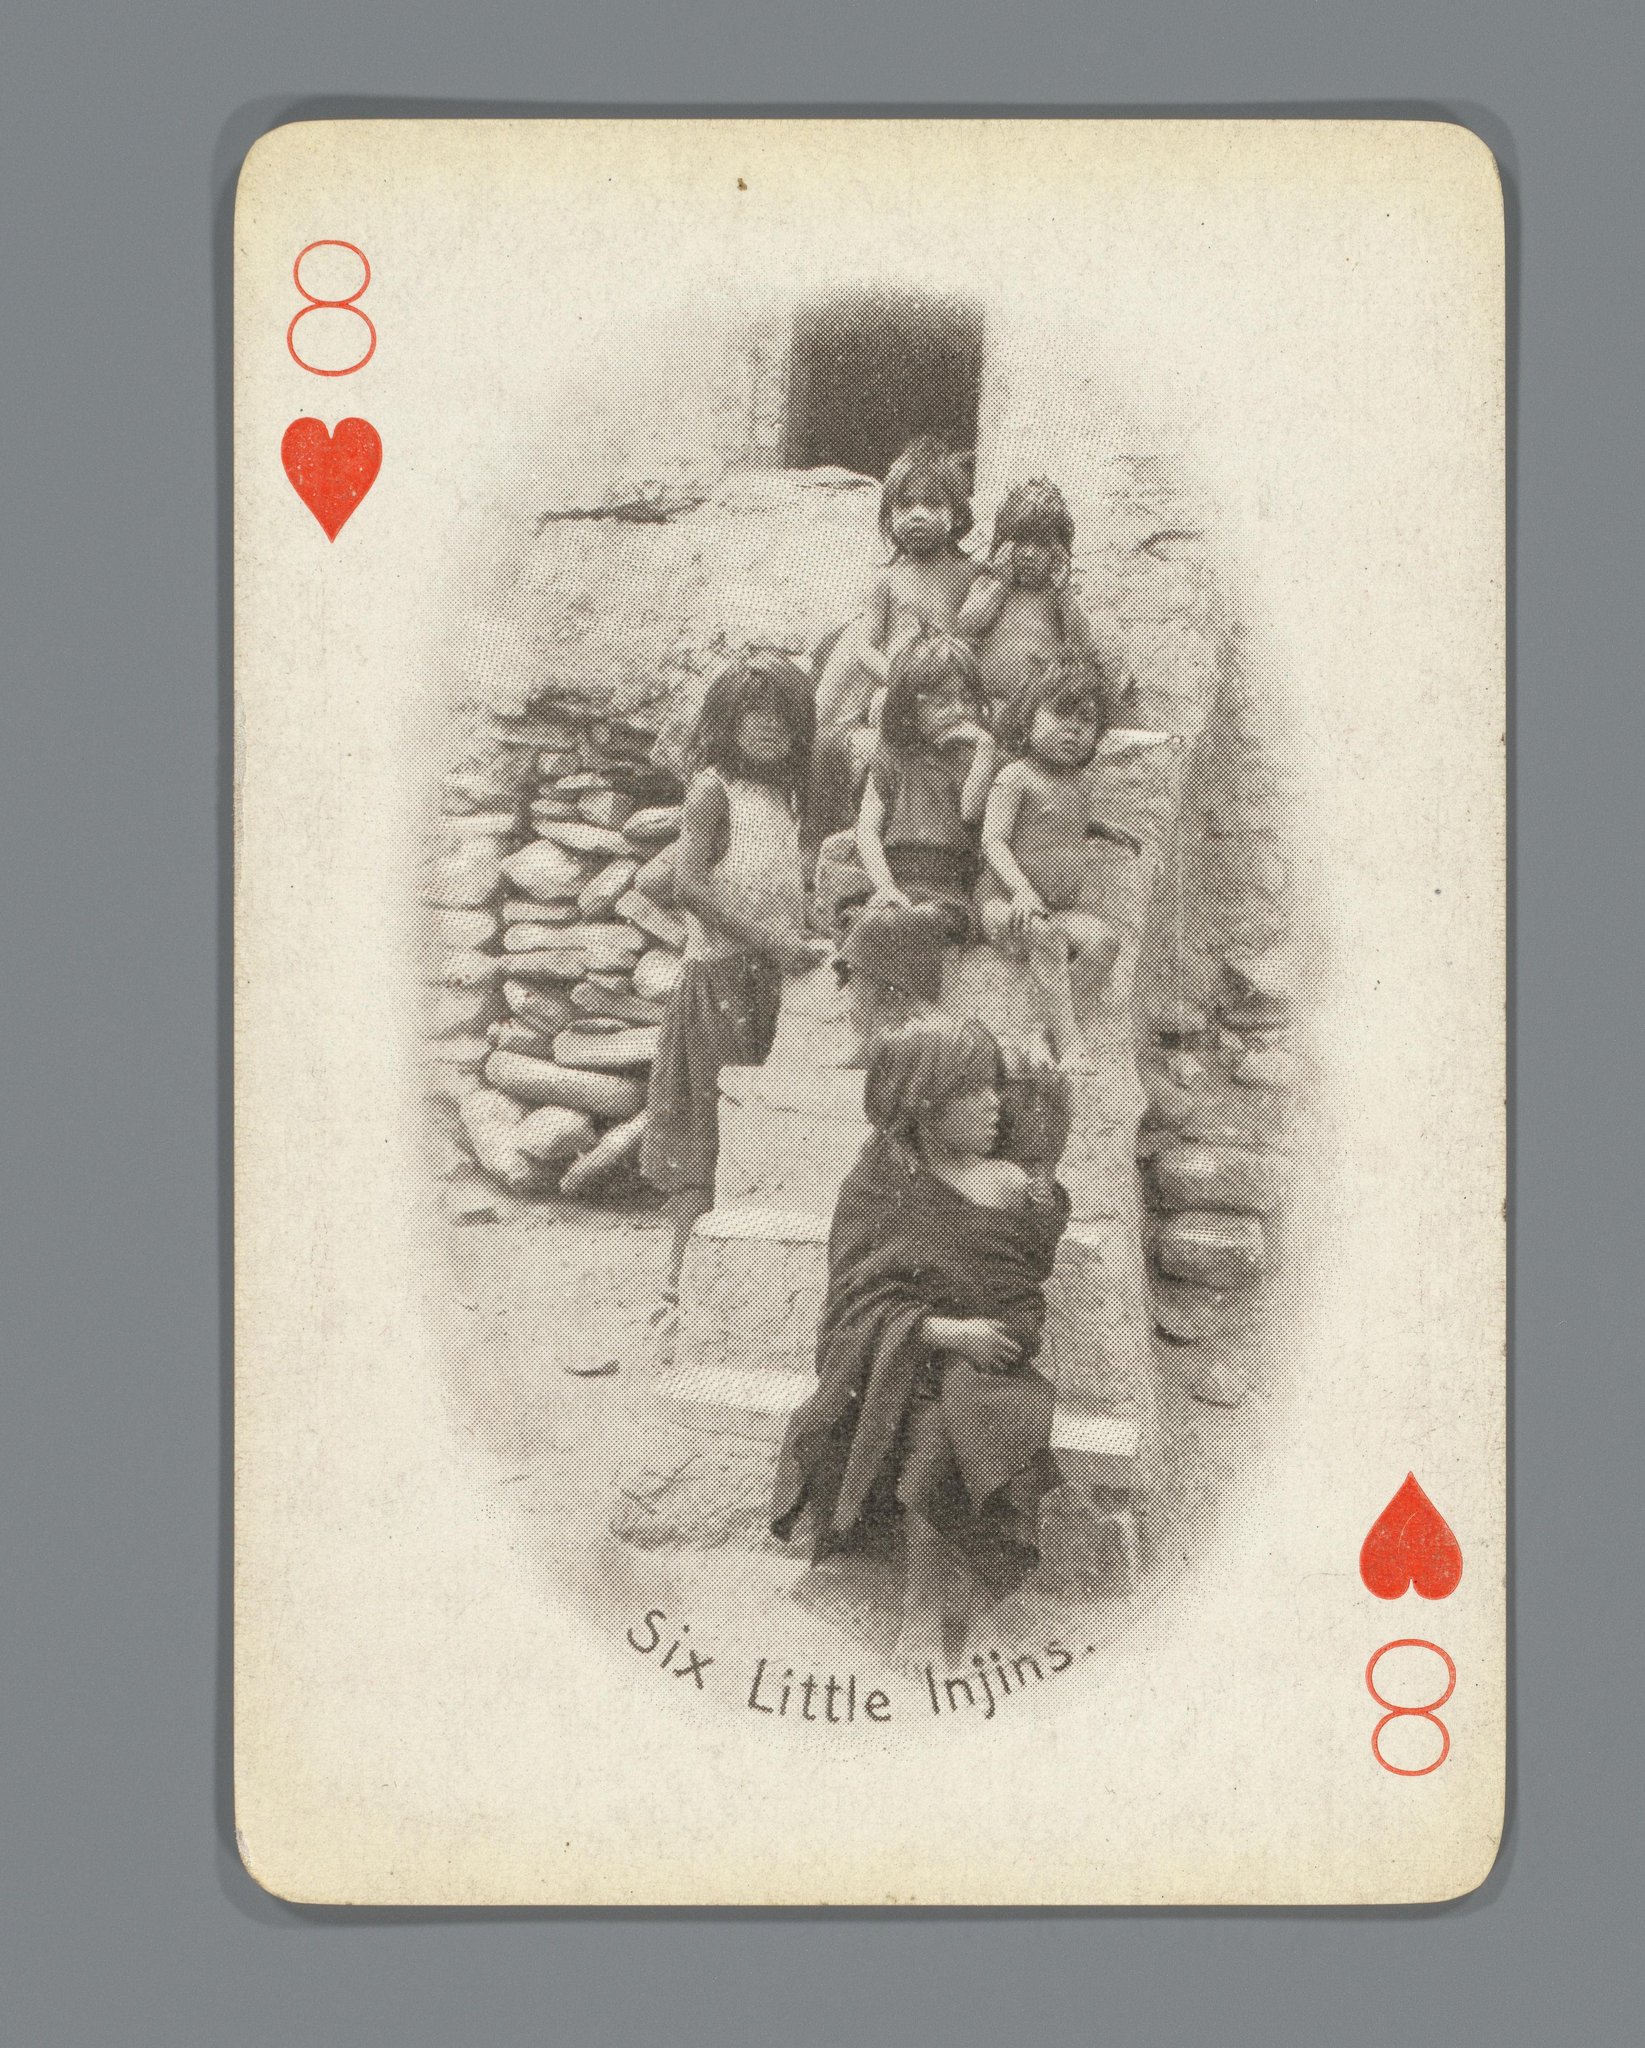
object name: playing card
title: Harten acht met groep kinderen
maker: adam clark vroman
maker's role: fotograaf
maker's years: 1856-1916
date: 1900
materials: paper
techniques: autotype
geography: united states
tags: united states of america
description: Speelkaart uit doosje met 53 speelkaarten met afbeeldingen in autotypie van Native Americans. De inhoud bevat een complete set speelkaarten inclusief joker.